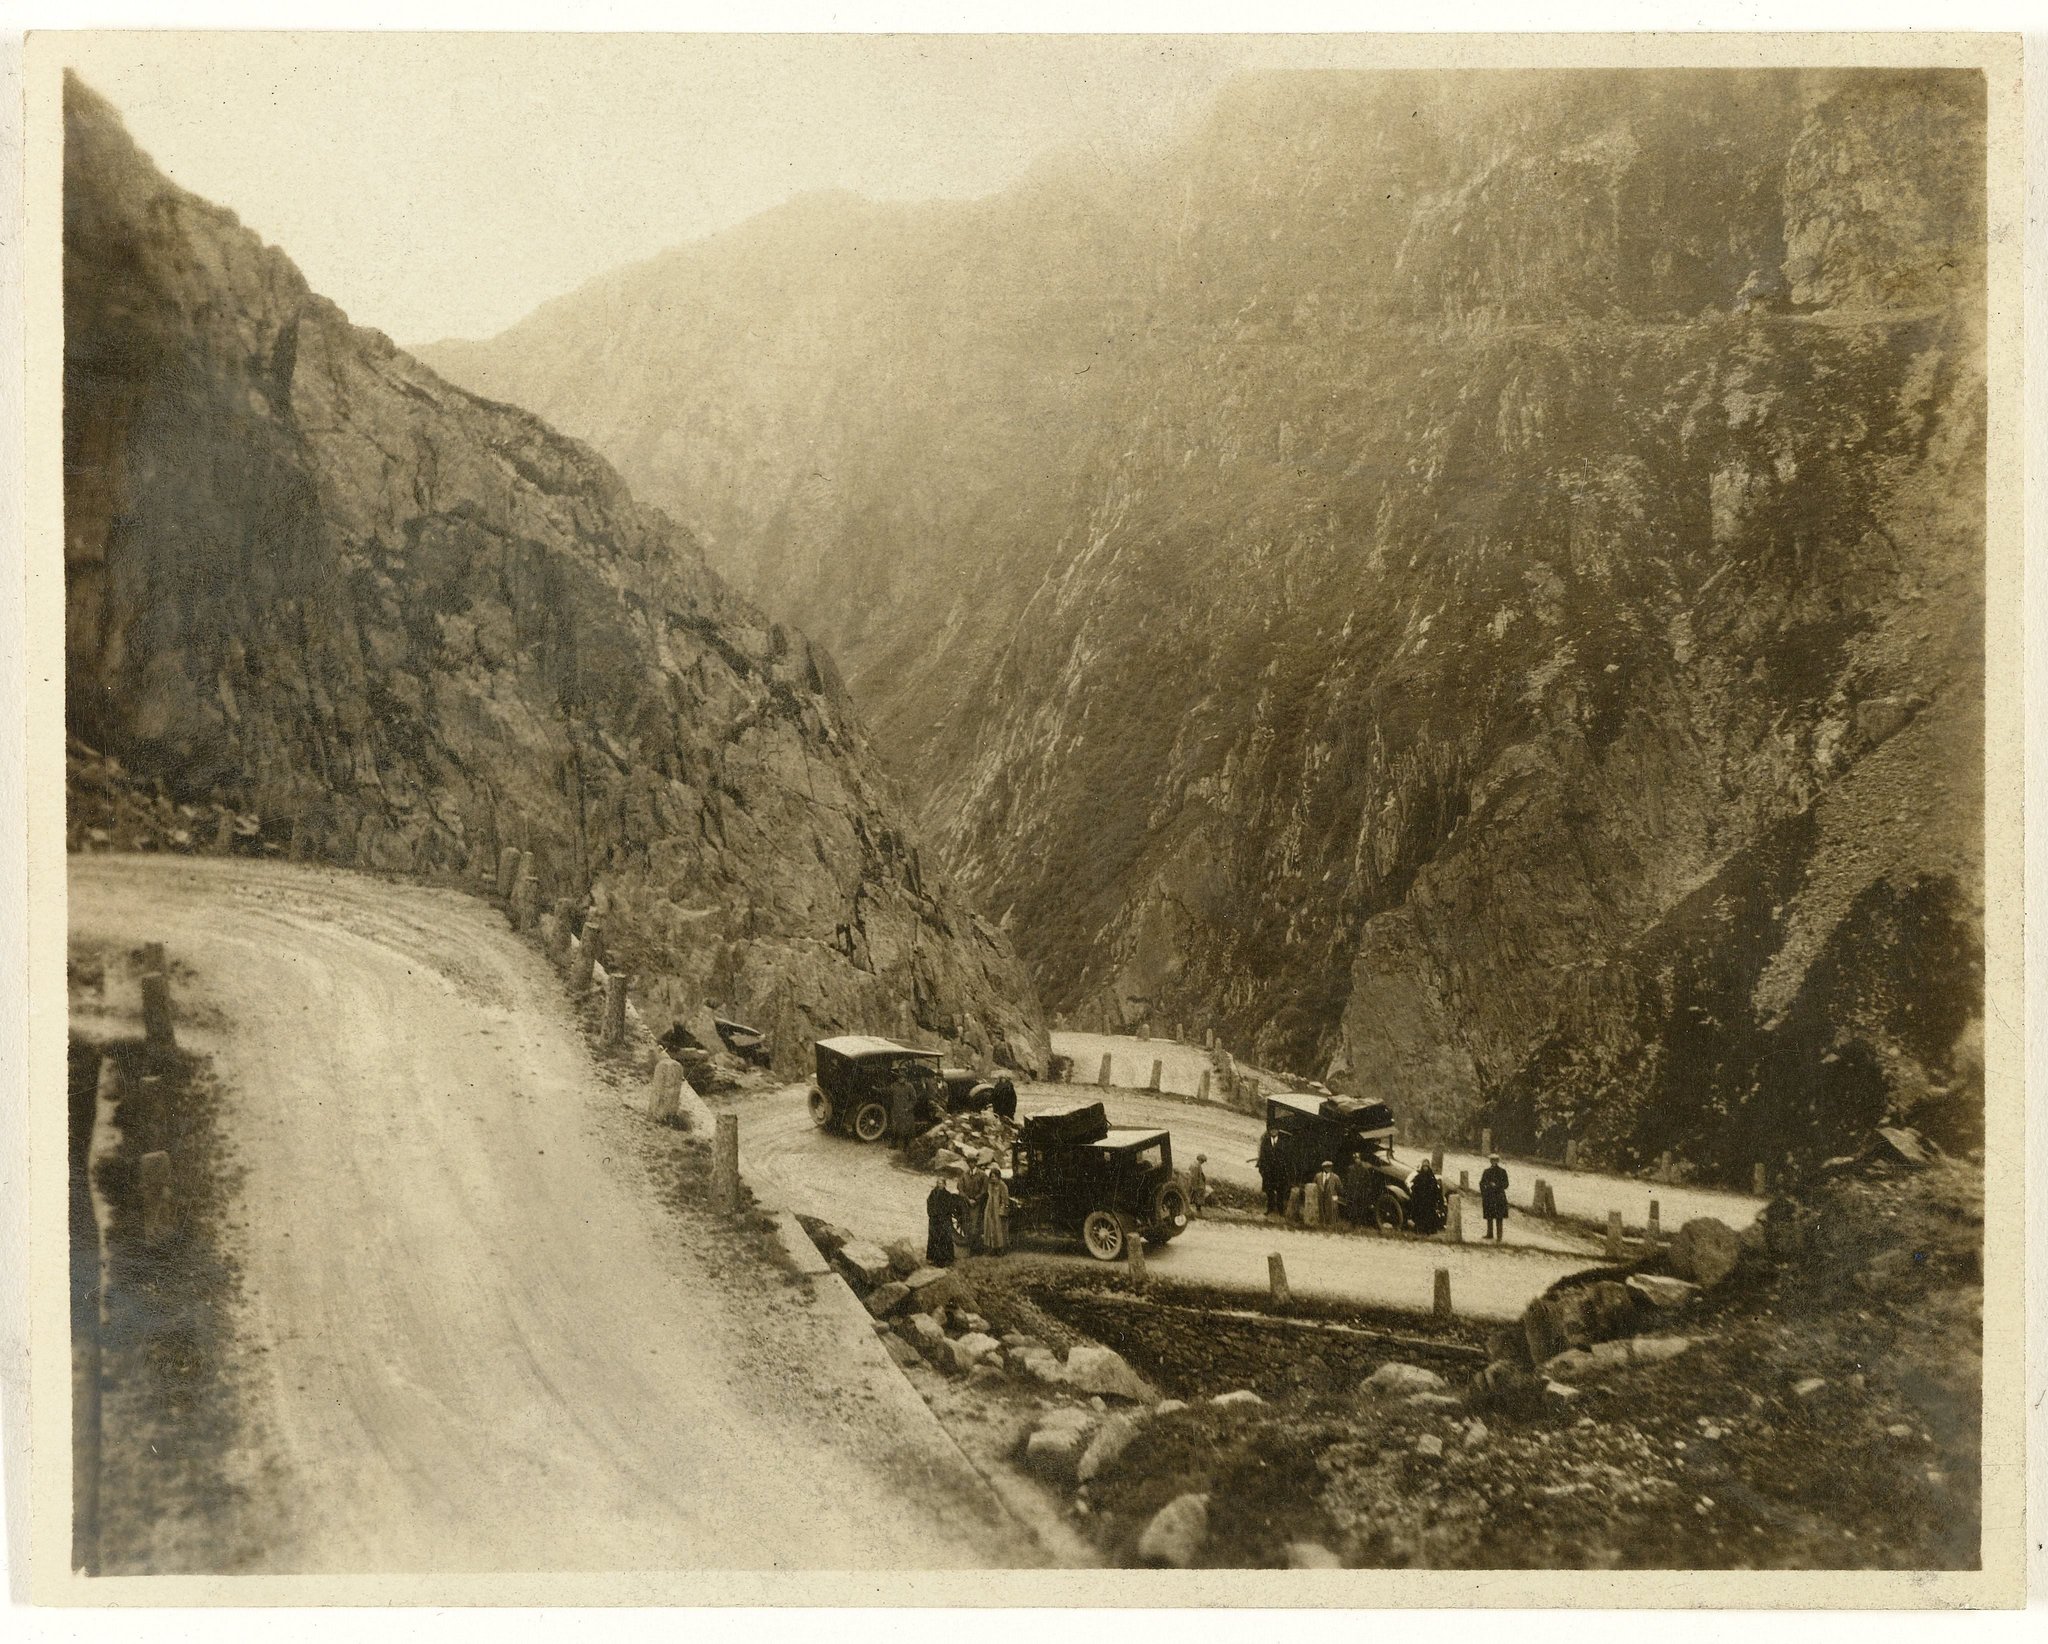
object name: photograph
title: Groep Amerikaanse toeristen bij hun auto's in de Alpen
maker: Anonymous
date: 1921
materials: paper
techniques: gelatin silver print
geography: north and central america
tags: tourism, mountain-range, snow peaks, automobile